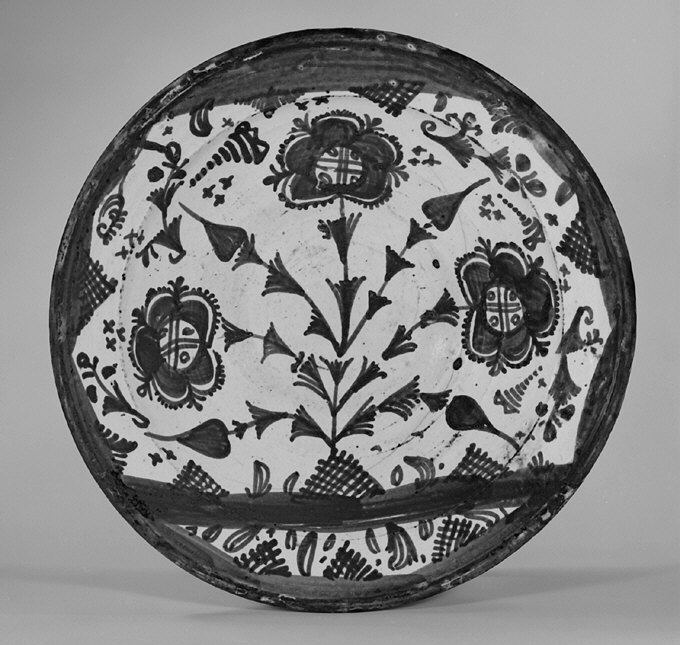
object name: plate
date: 1601-1700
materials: earthenware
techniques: glazing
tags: flowers